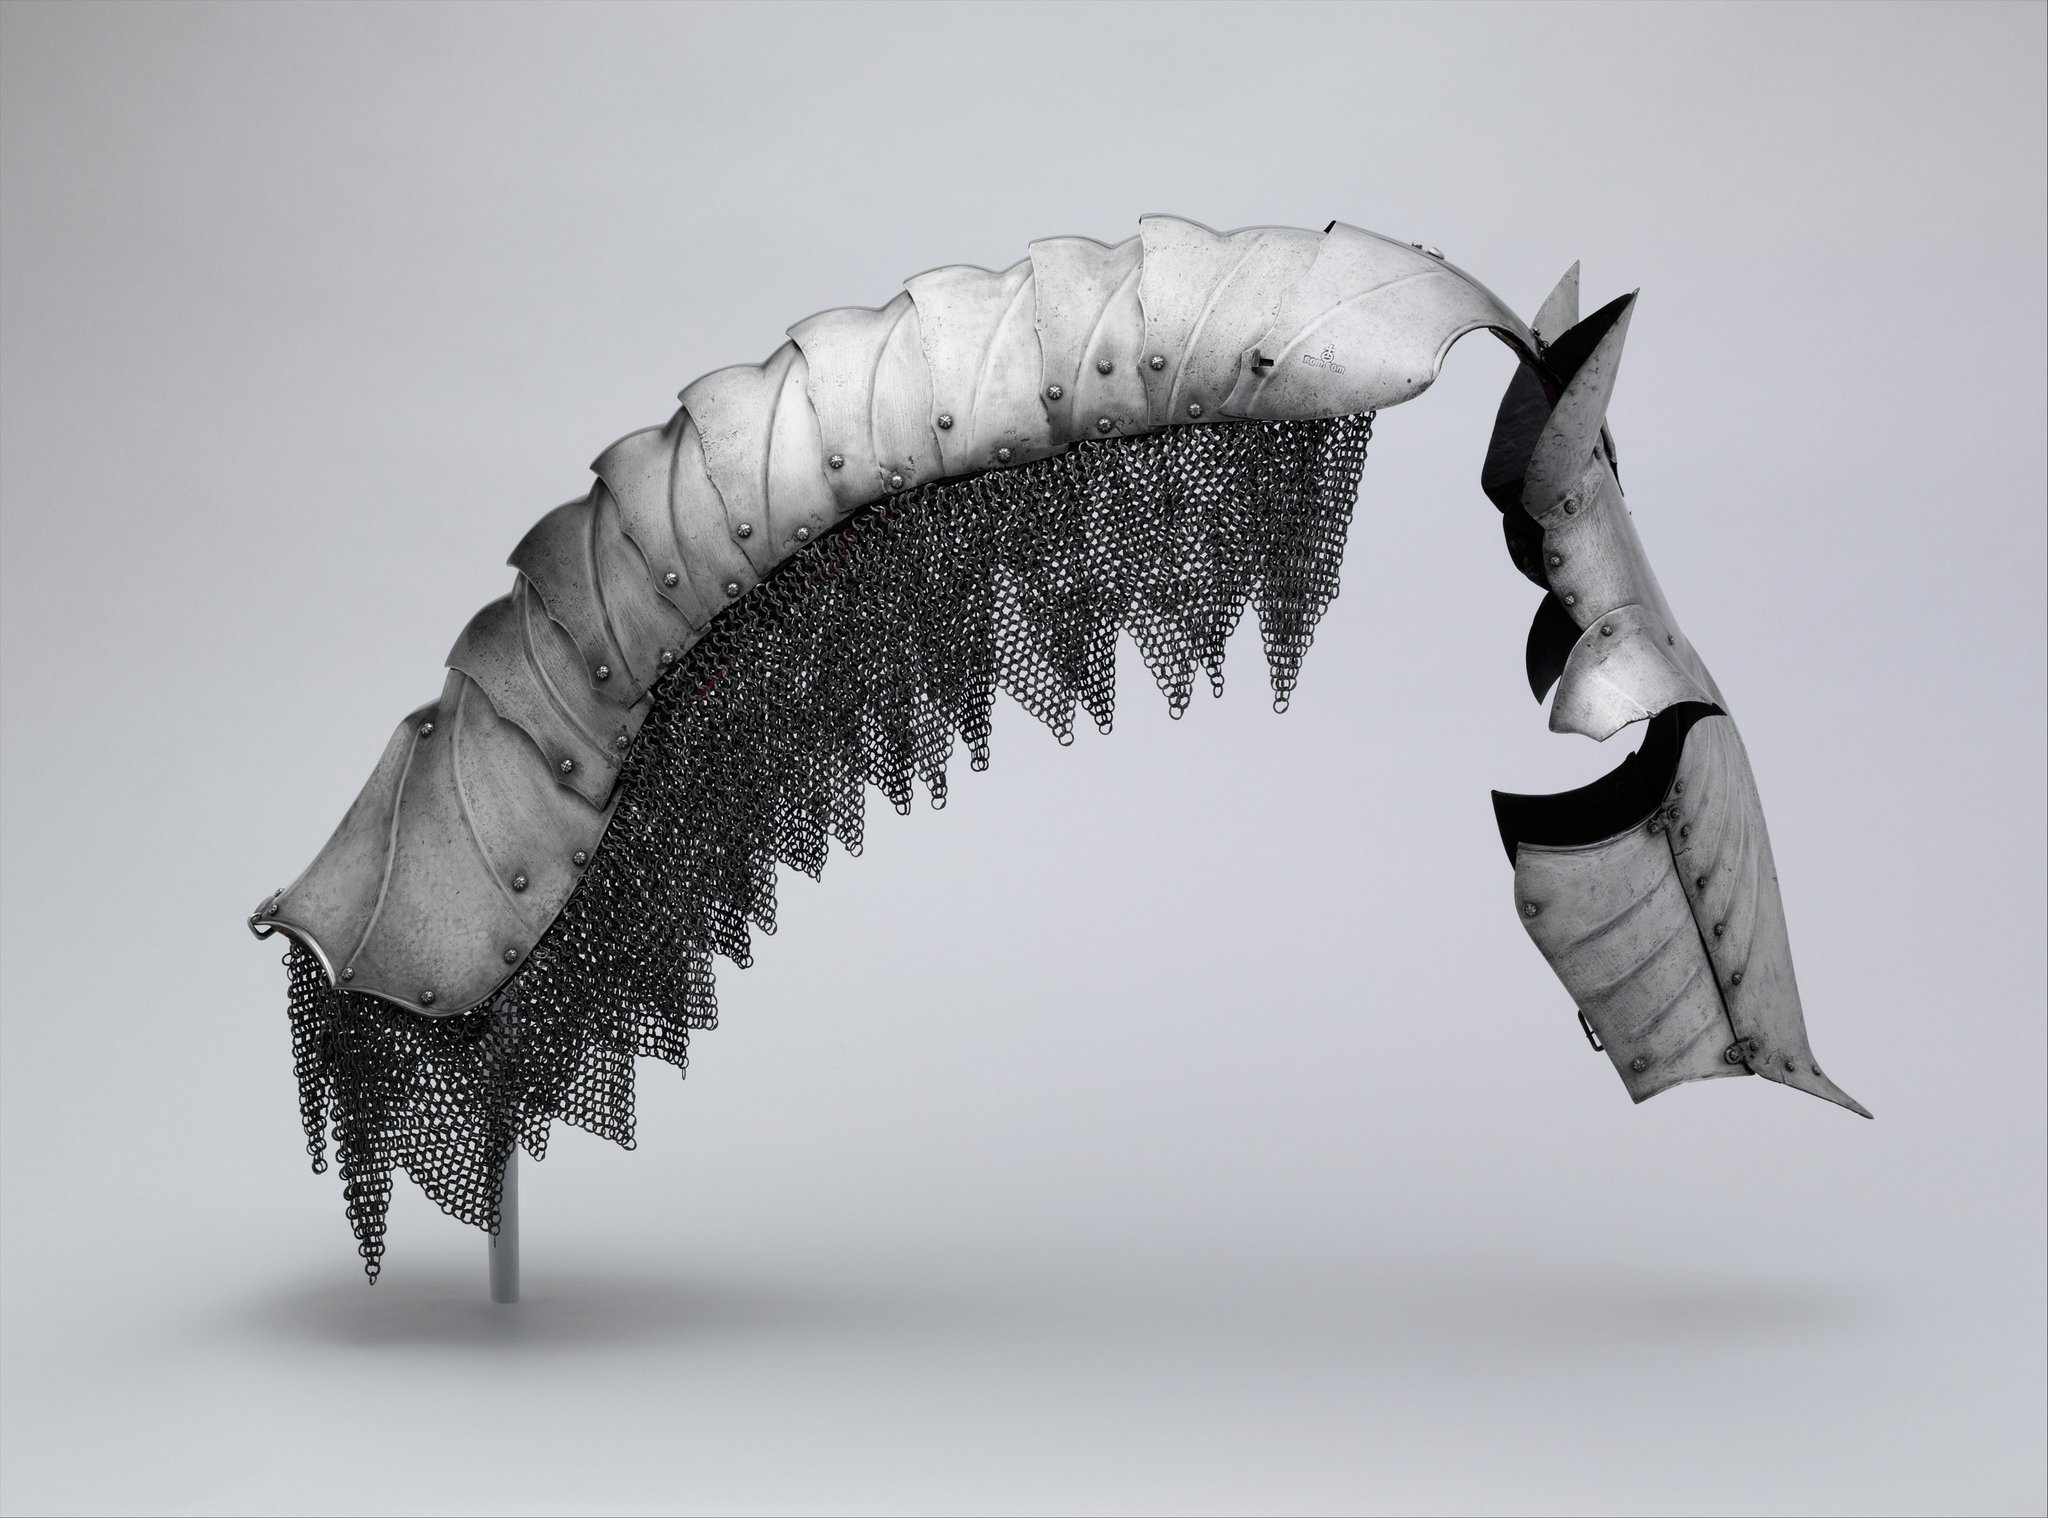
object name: crinet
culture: franco-italian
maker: romain des ursins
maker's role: armorer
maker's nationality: italian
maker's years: 1493-1495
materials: steel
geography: italy